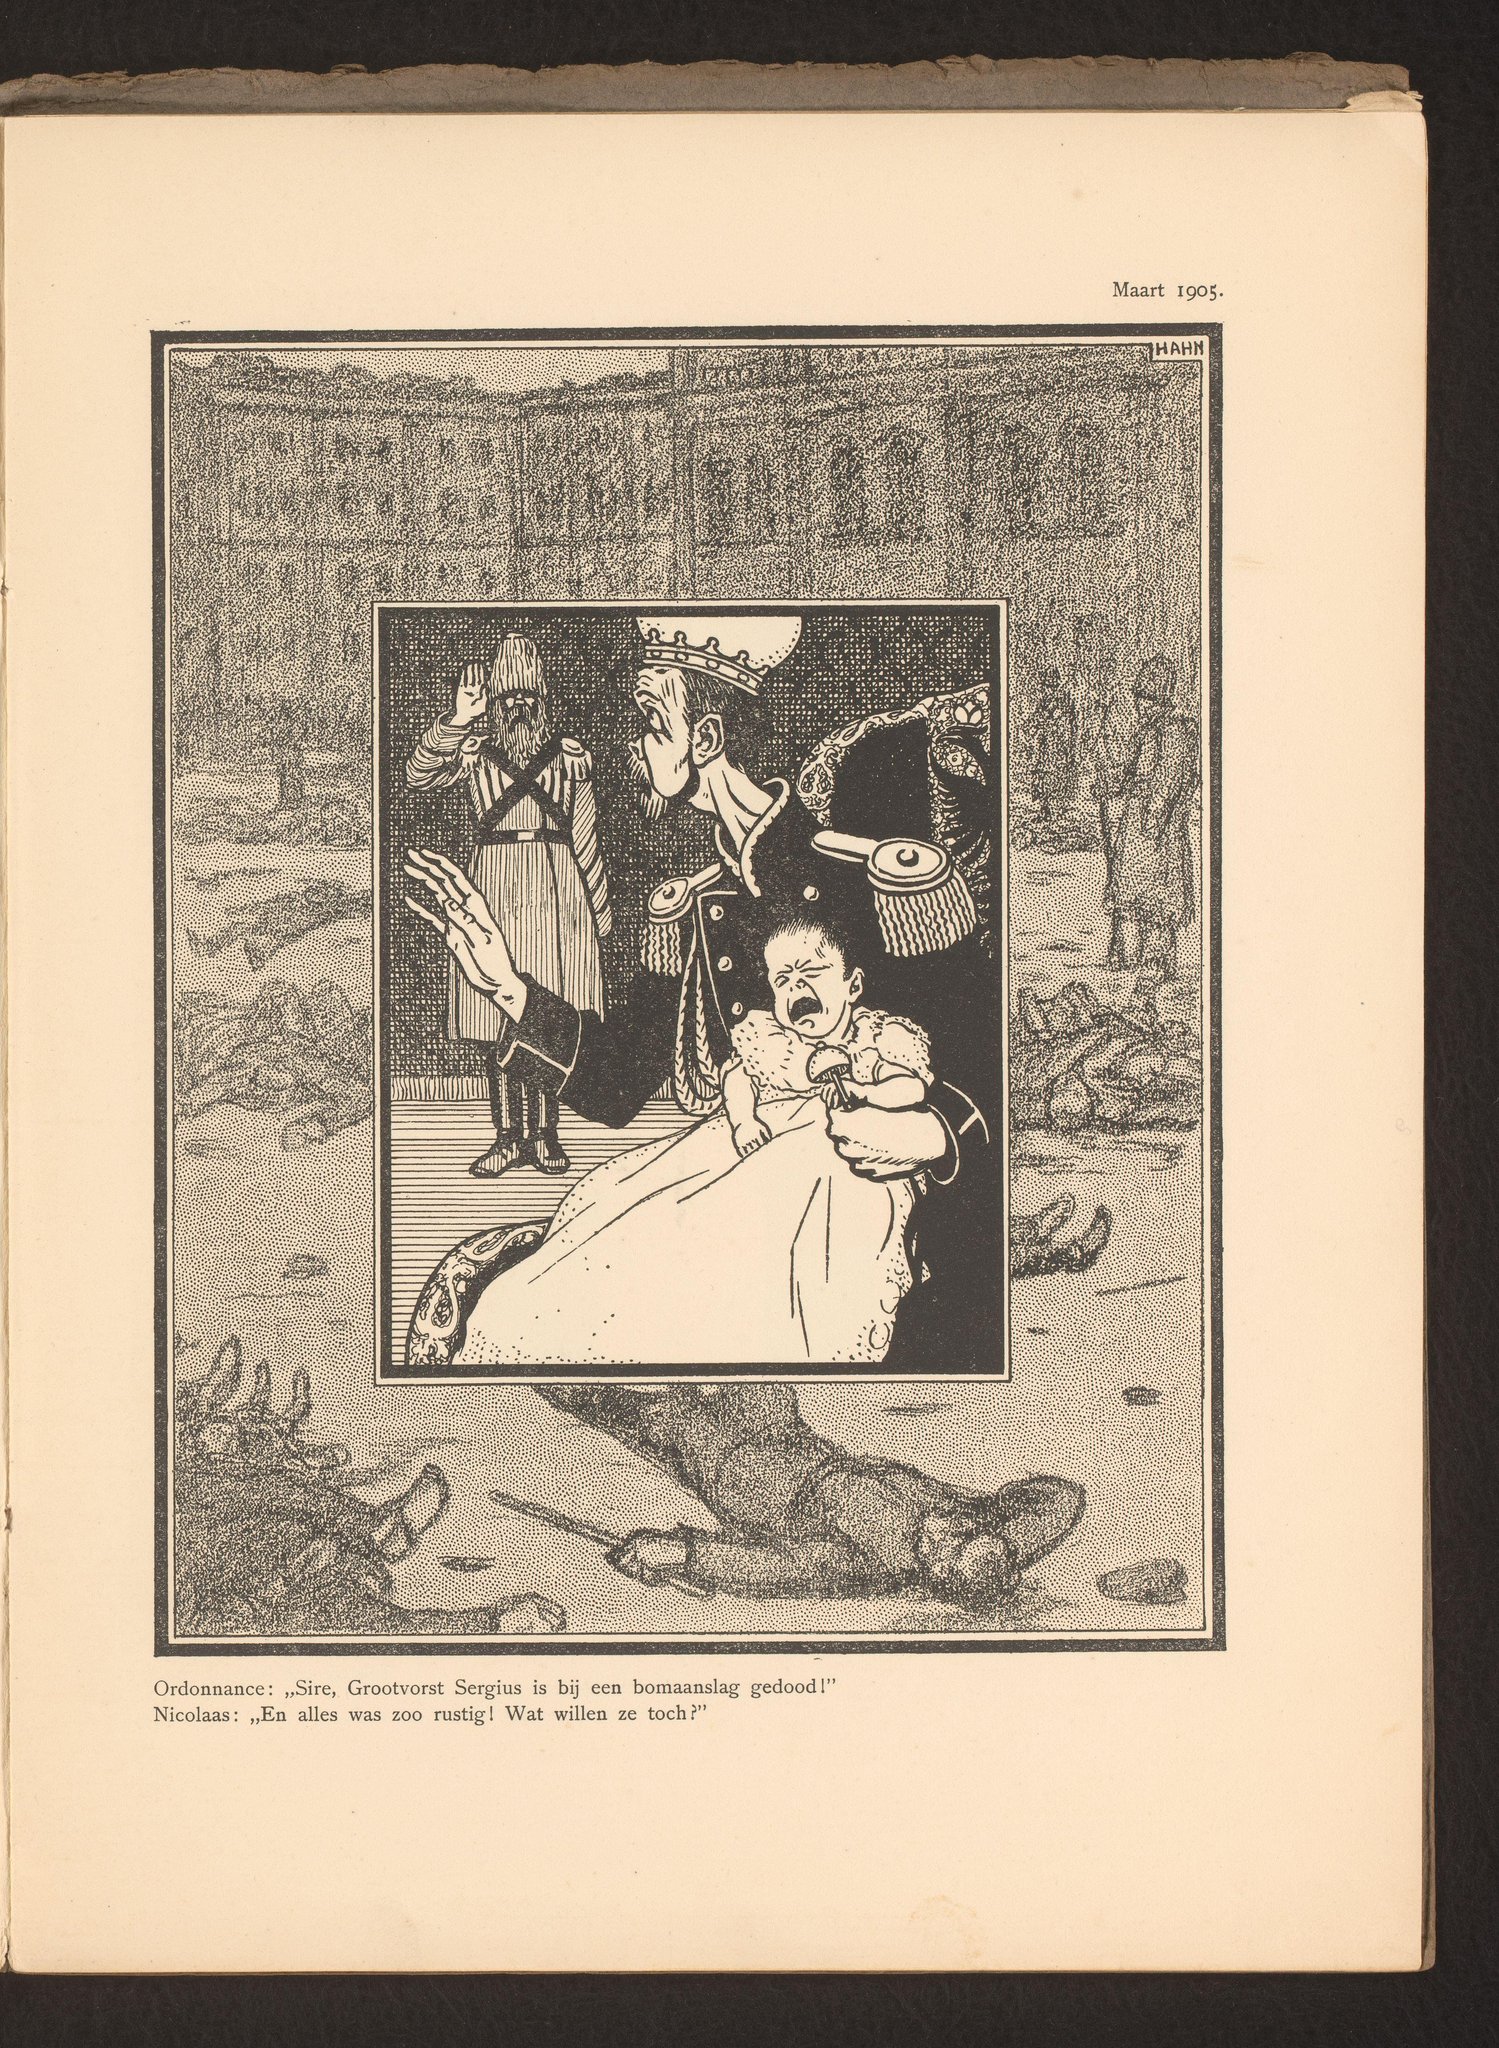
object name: cartoon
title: Dood van grootvorst Sergej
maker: albert hahn (i)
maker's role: draughtsman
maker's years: 1877-1918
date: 1903-1905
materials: paper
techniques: autotype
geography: netherlands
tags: attempt, political murder, political caricatures and satires, russia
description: Een boodschapper brengt tsaar Nicolaas II het nieuws dat grootvorst Sergej bij een bomaanslag is gedood, maart 1905. Onderdeel van het boek 'Albert Hahn Prenten', heruitgave van een selectie politieke prenten uit de periode 1902-1906.